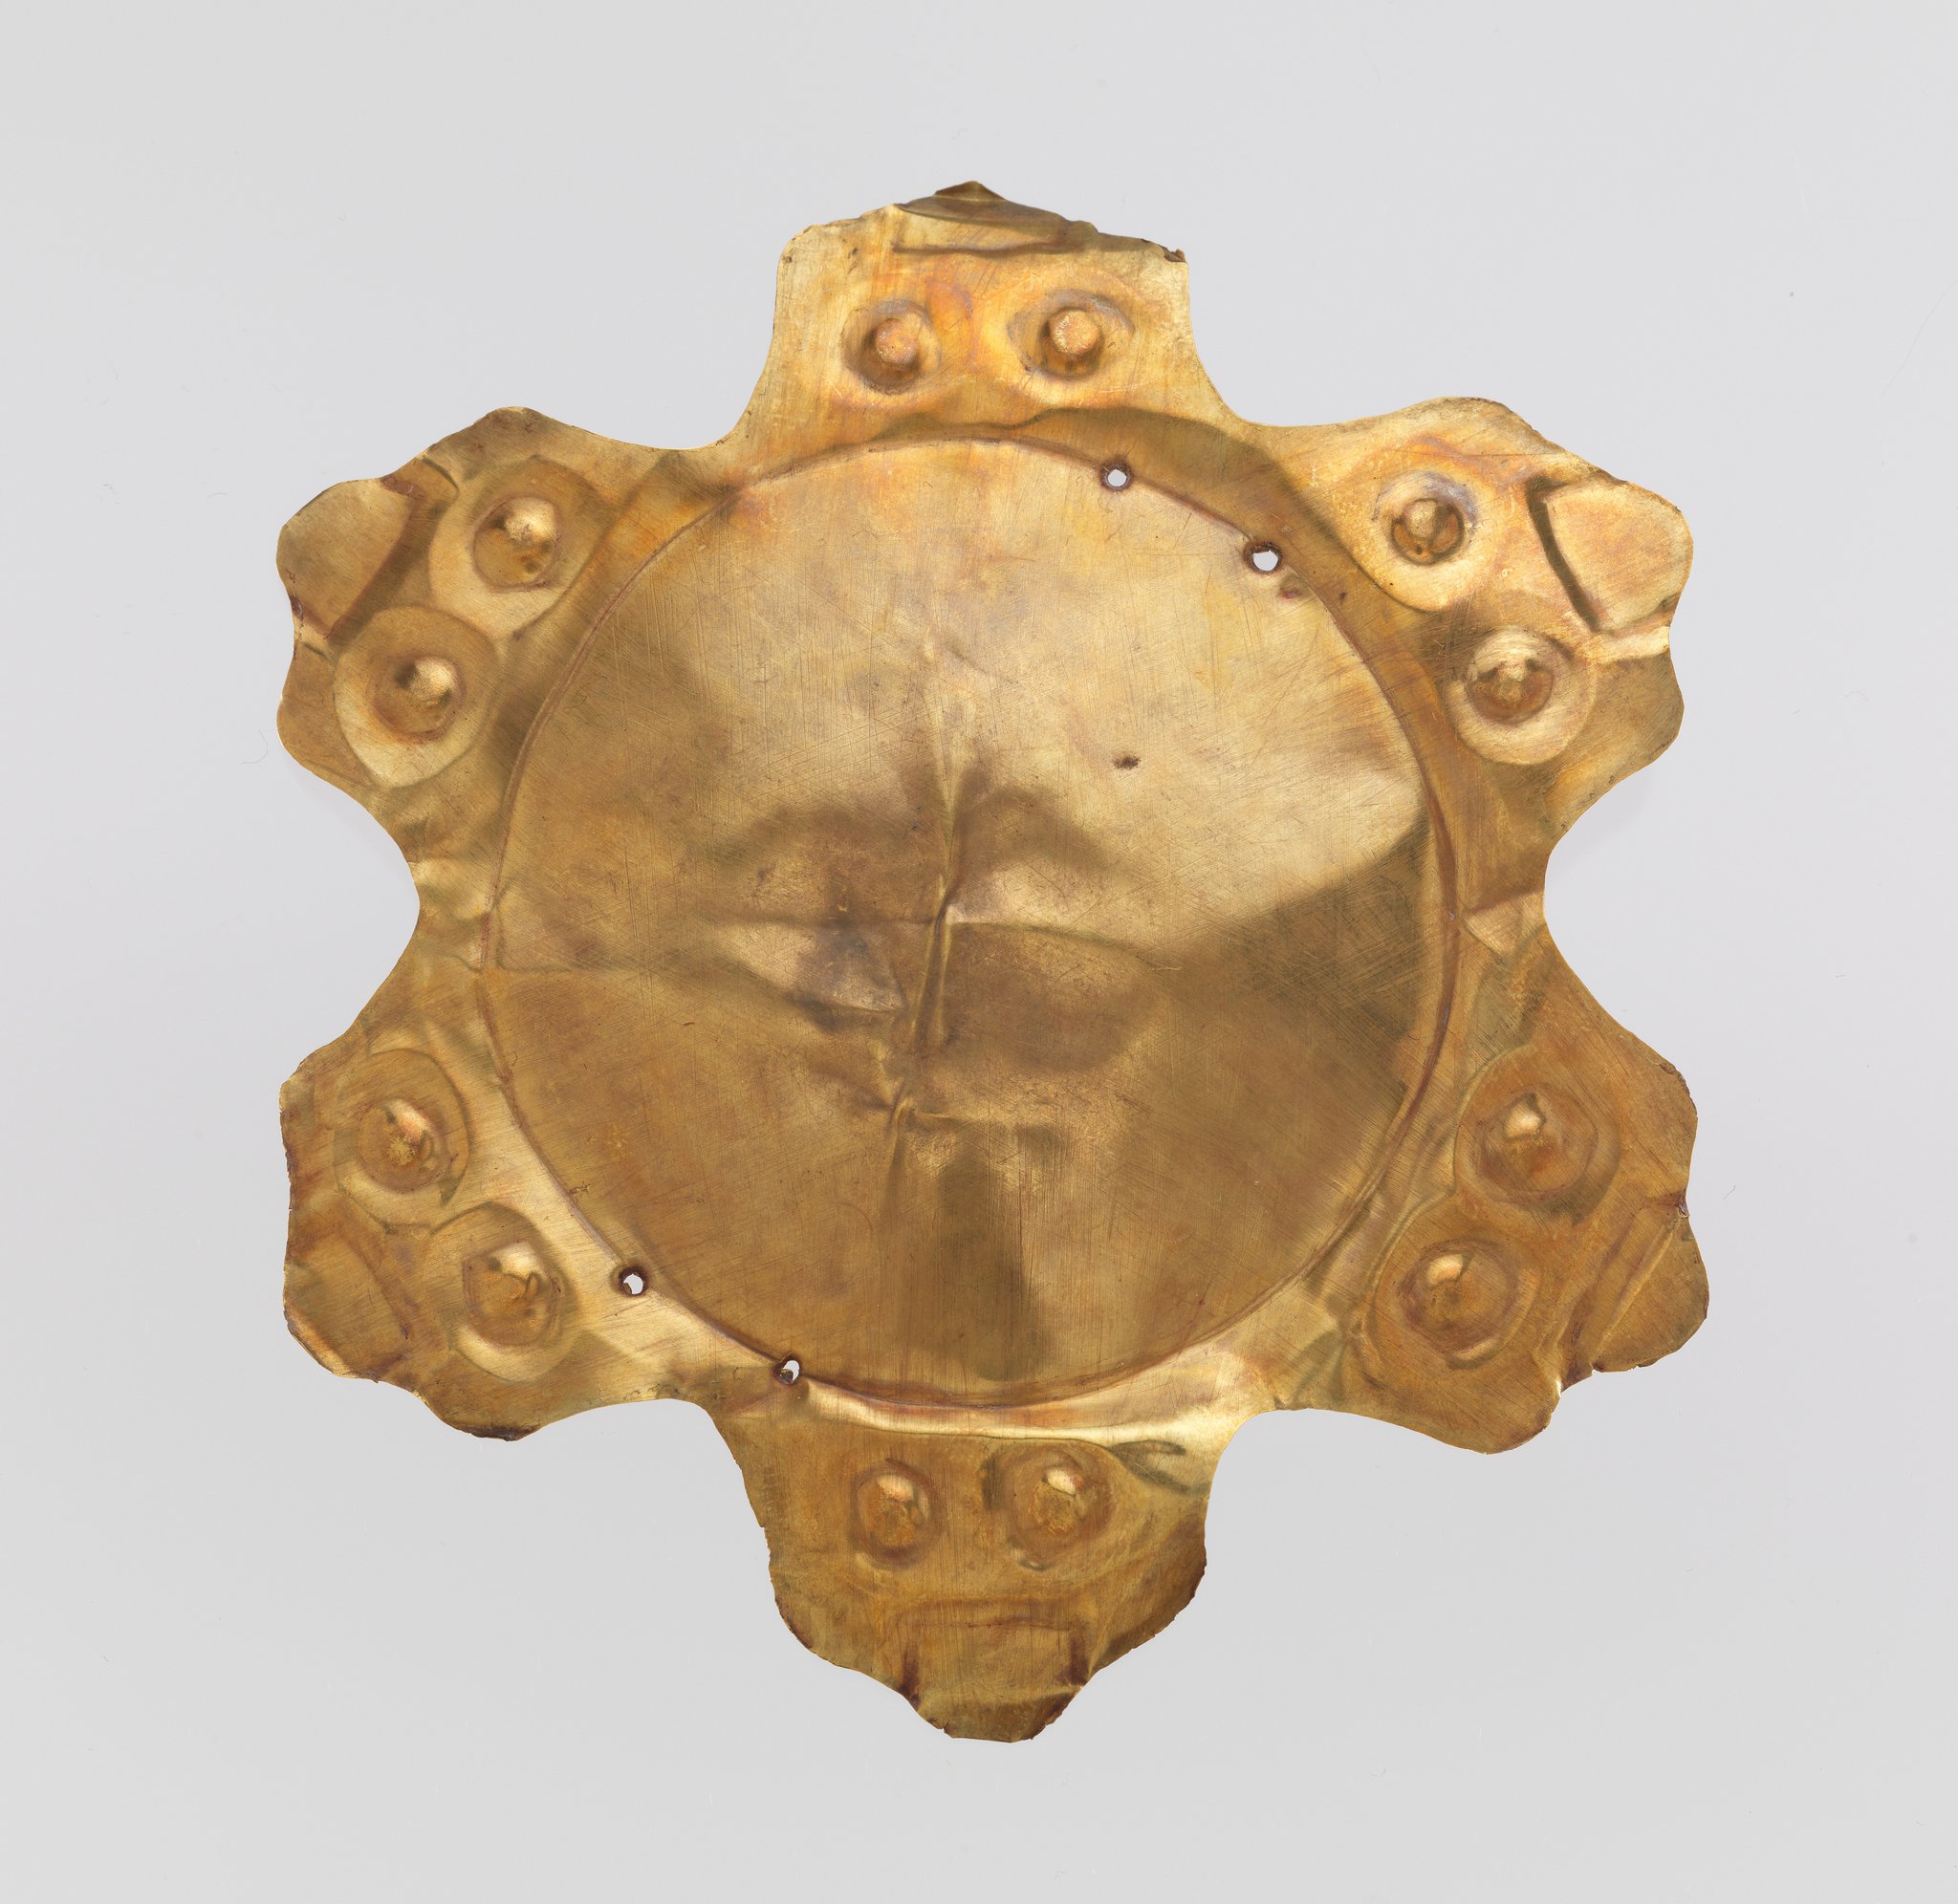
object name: ornament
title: Textile ornament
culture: nasca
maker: nasca artist(s)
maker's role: artist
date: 1-700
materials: gold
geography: peru